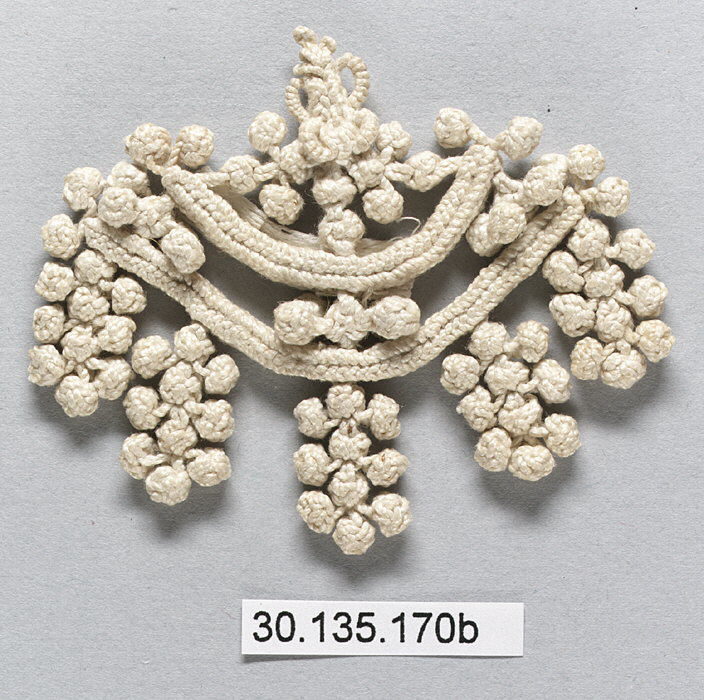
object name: tassel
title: Pair of tassels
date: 1601-1700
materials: linen